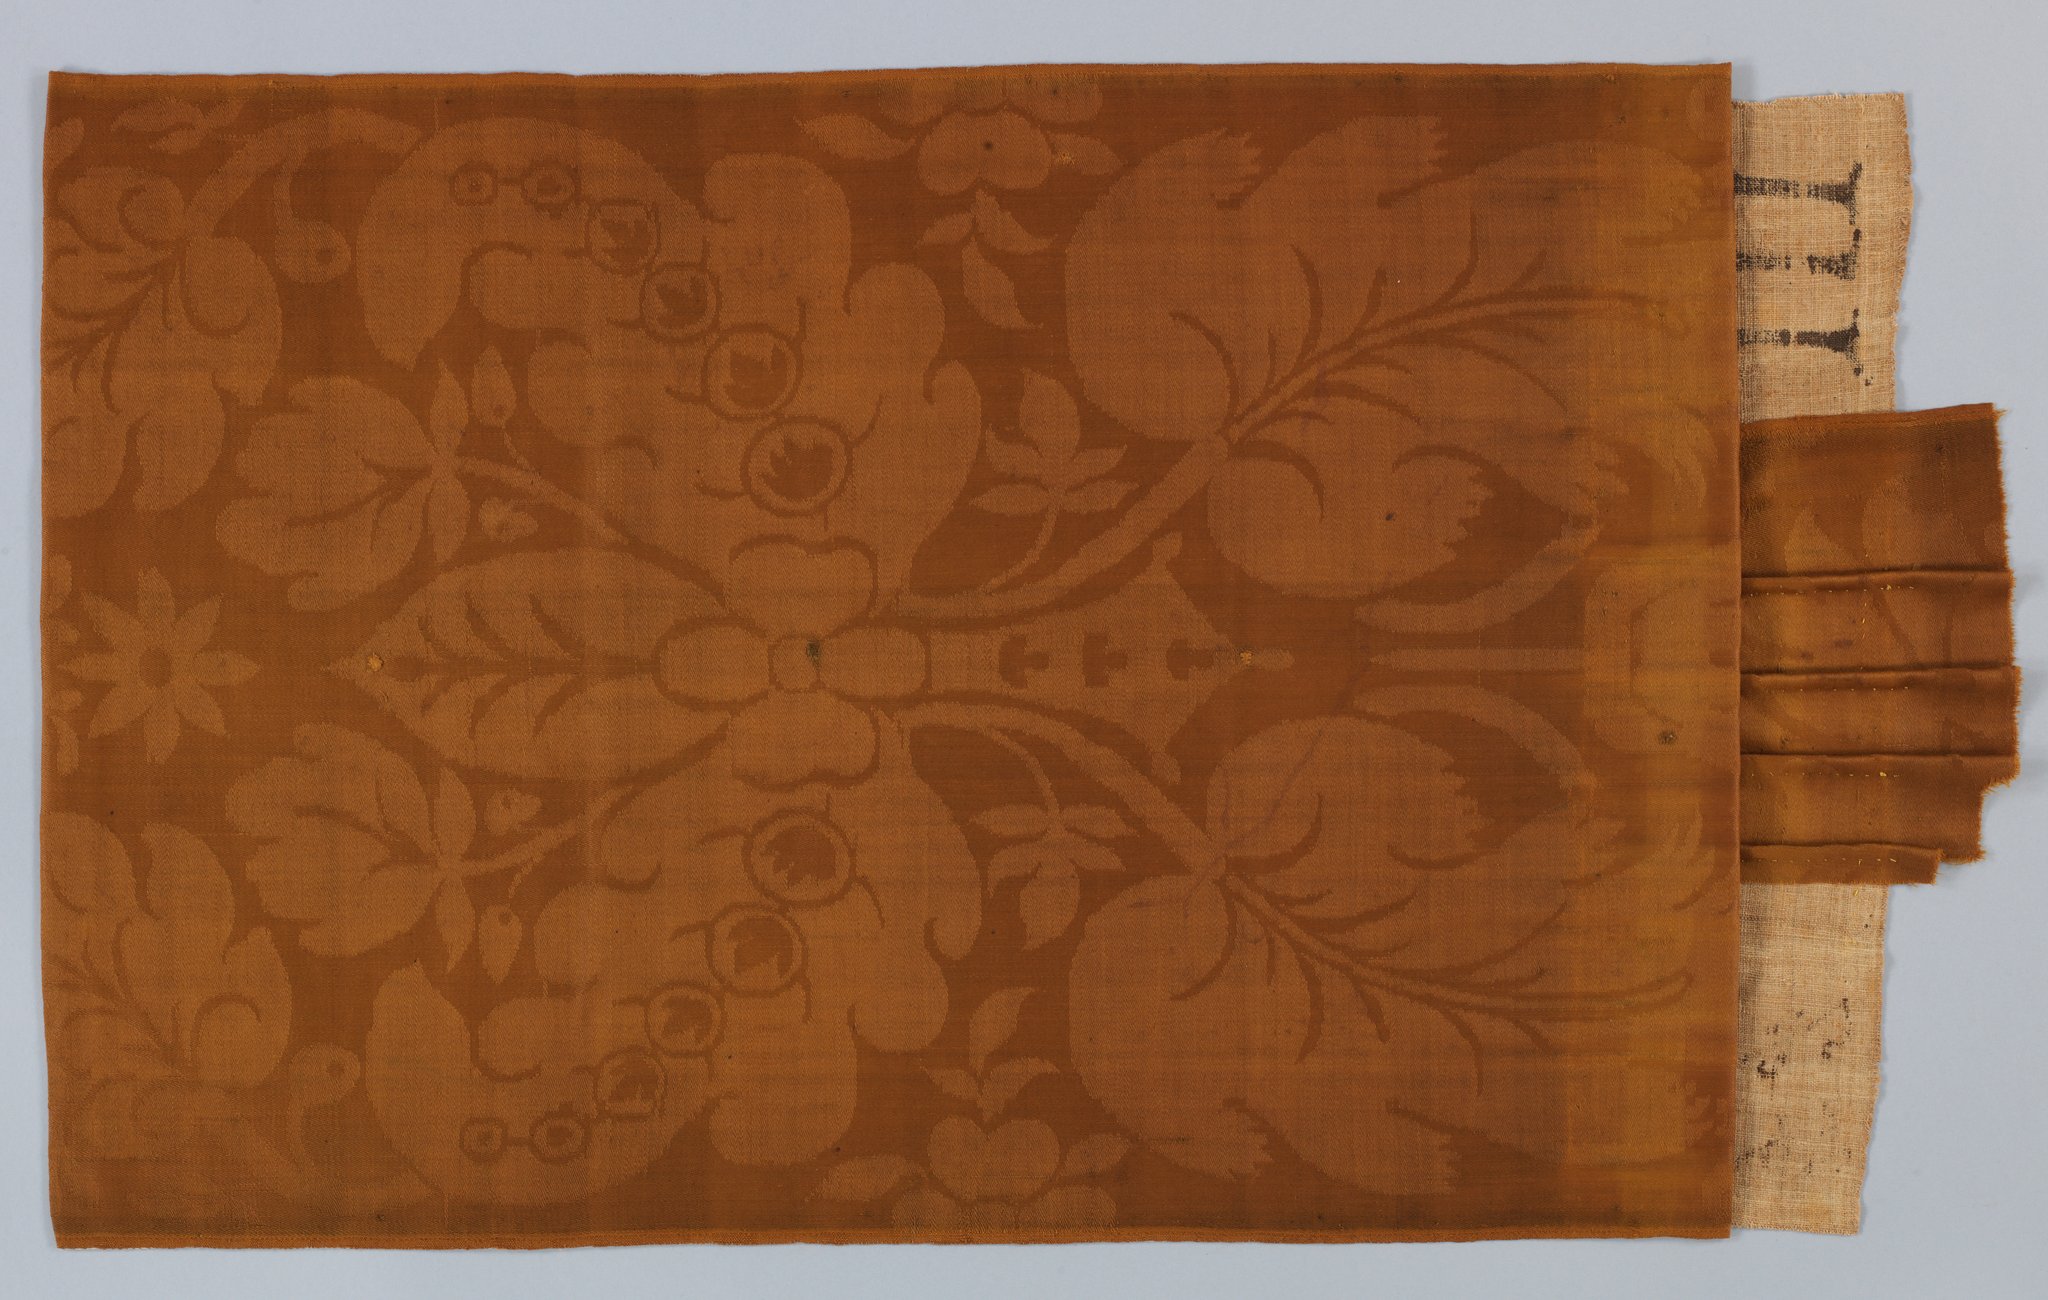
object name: piece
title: Length of wool damask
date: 1710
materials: wool